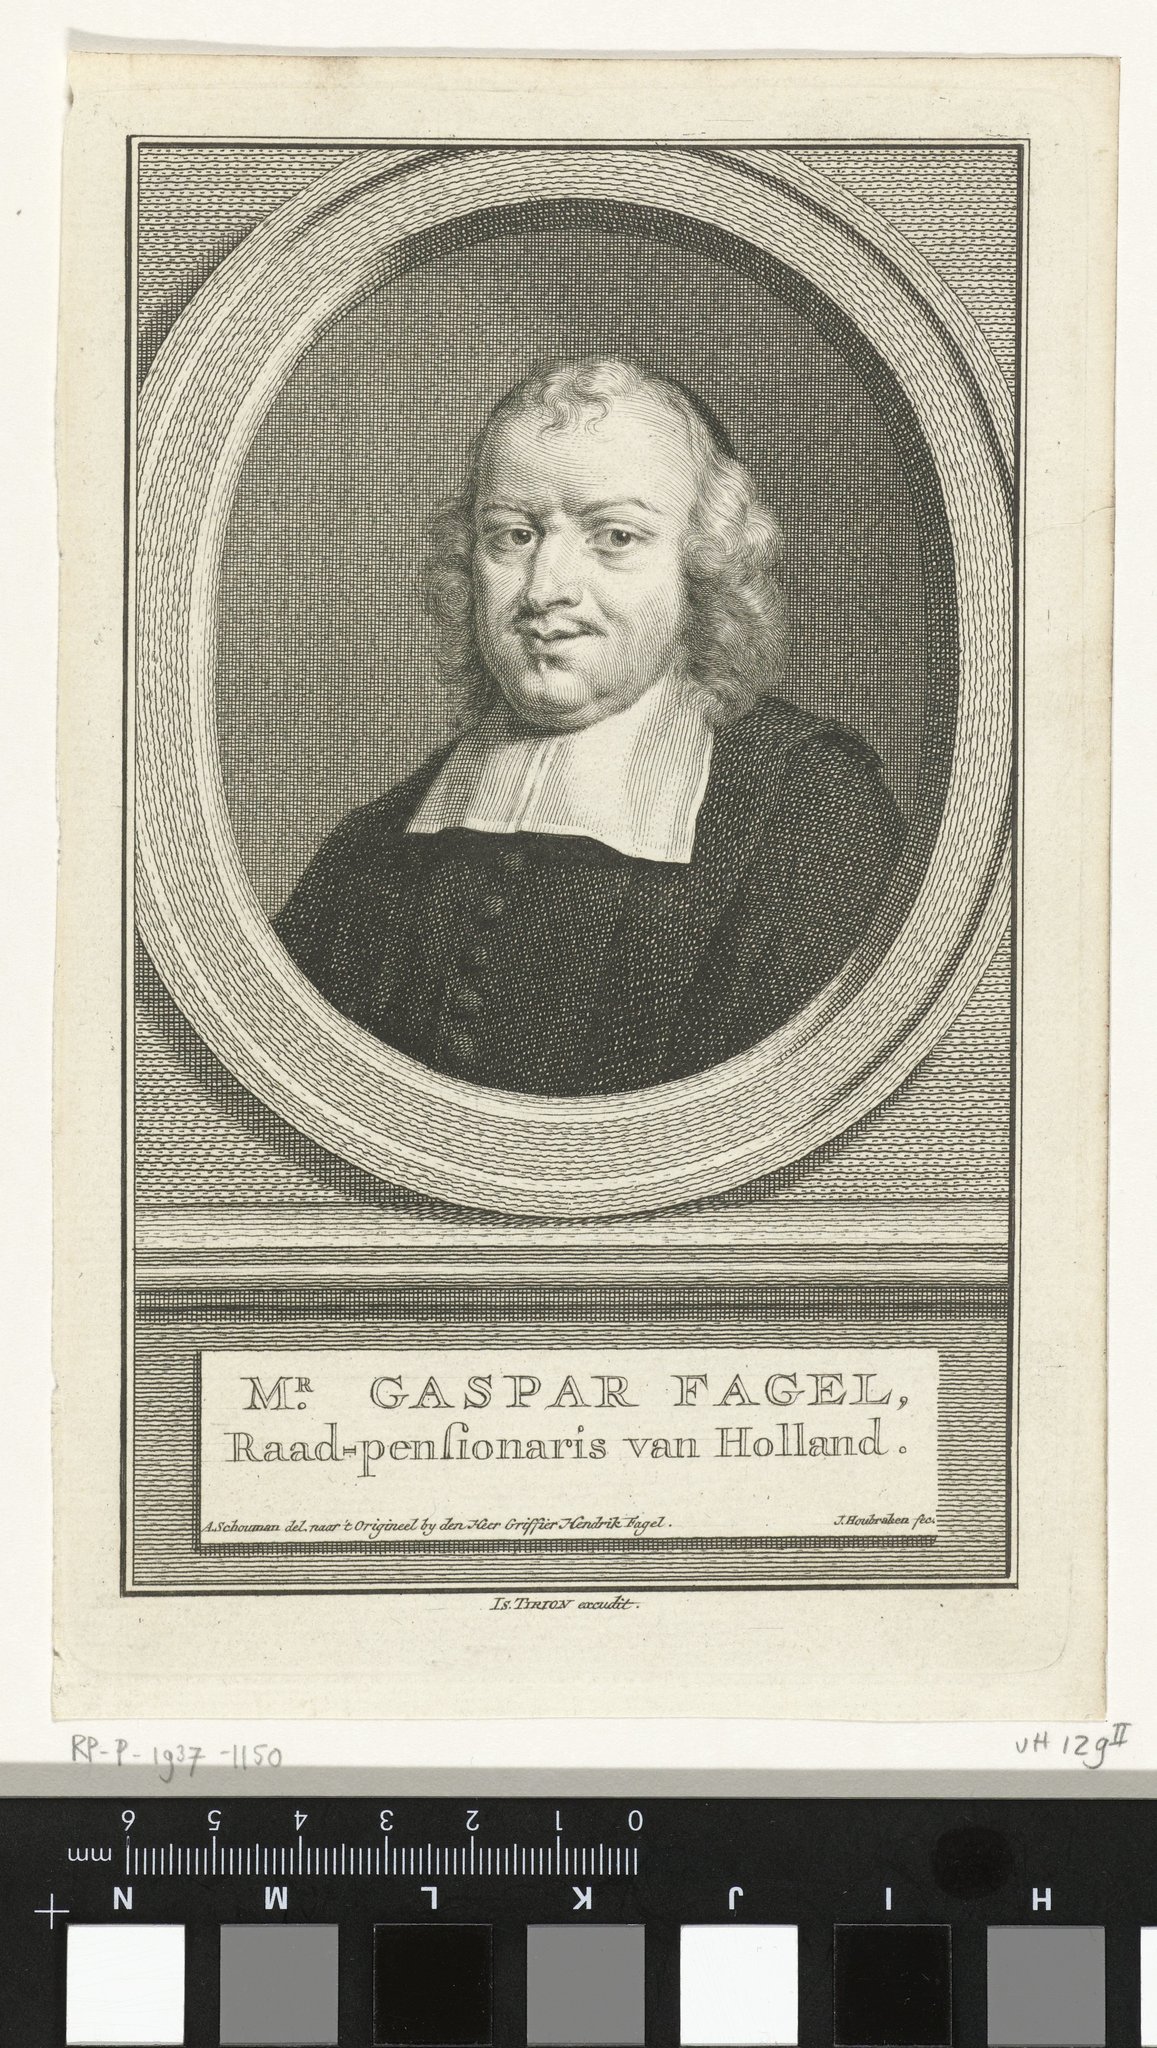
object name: print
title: Portret van François Fagel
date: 1749-1759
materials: paper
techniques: engraving, etching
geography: amsterdam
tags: politician, gaspar fagel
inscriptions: collector's mark: Lugt 2228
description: Prent ook gebruikt in: Jan Wagenaar, Vaderlandsche historie, vervattende de geschiedenissen der nu Vereenigde Nederlanden, inzonderheid die van Holland (...), 21 delen. Amsterdam, Isaak Tirion, 1749-59.